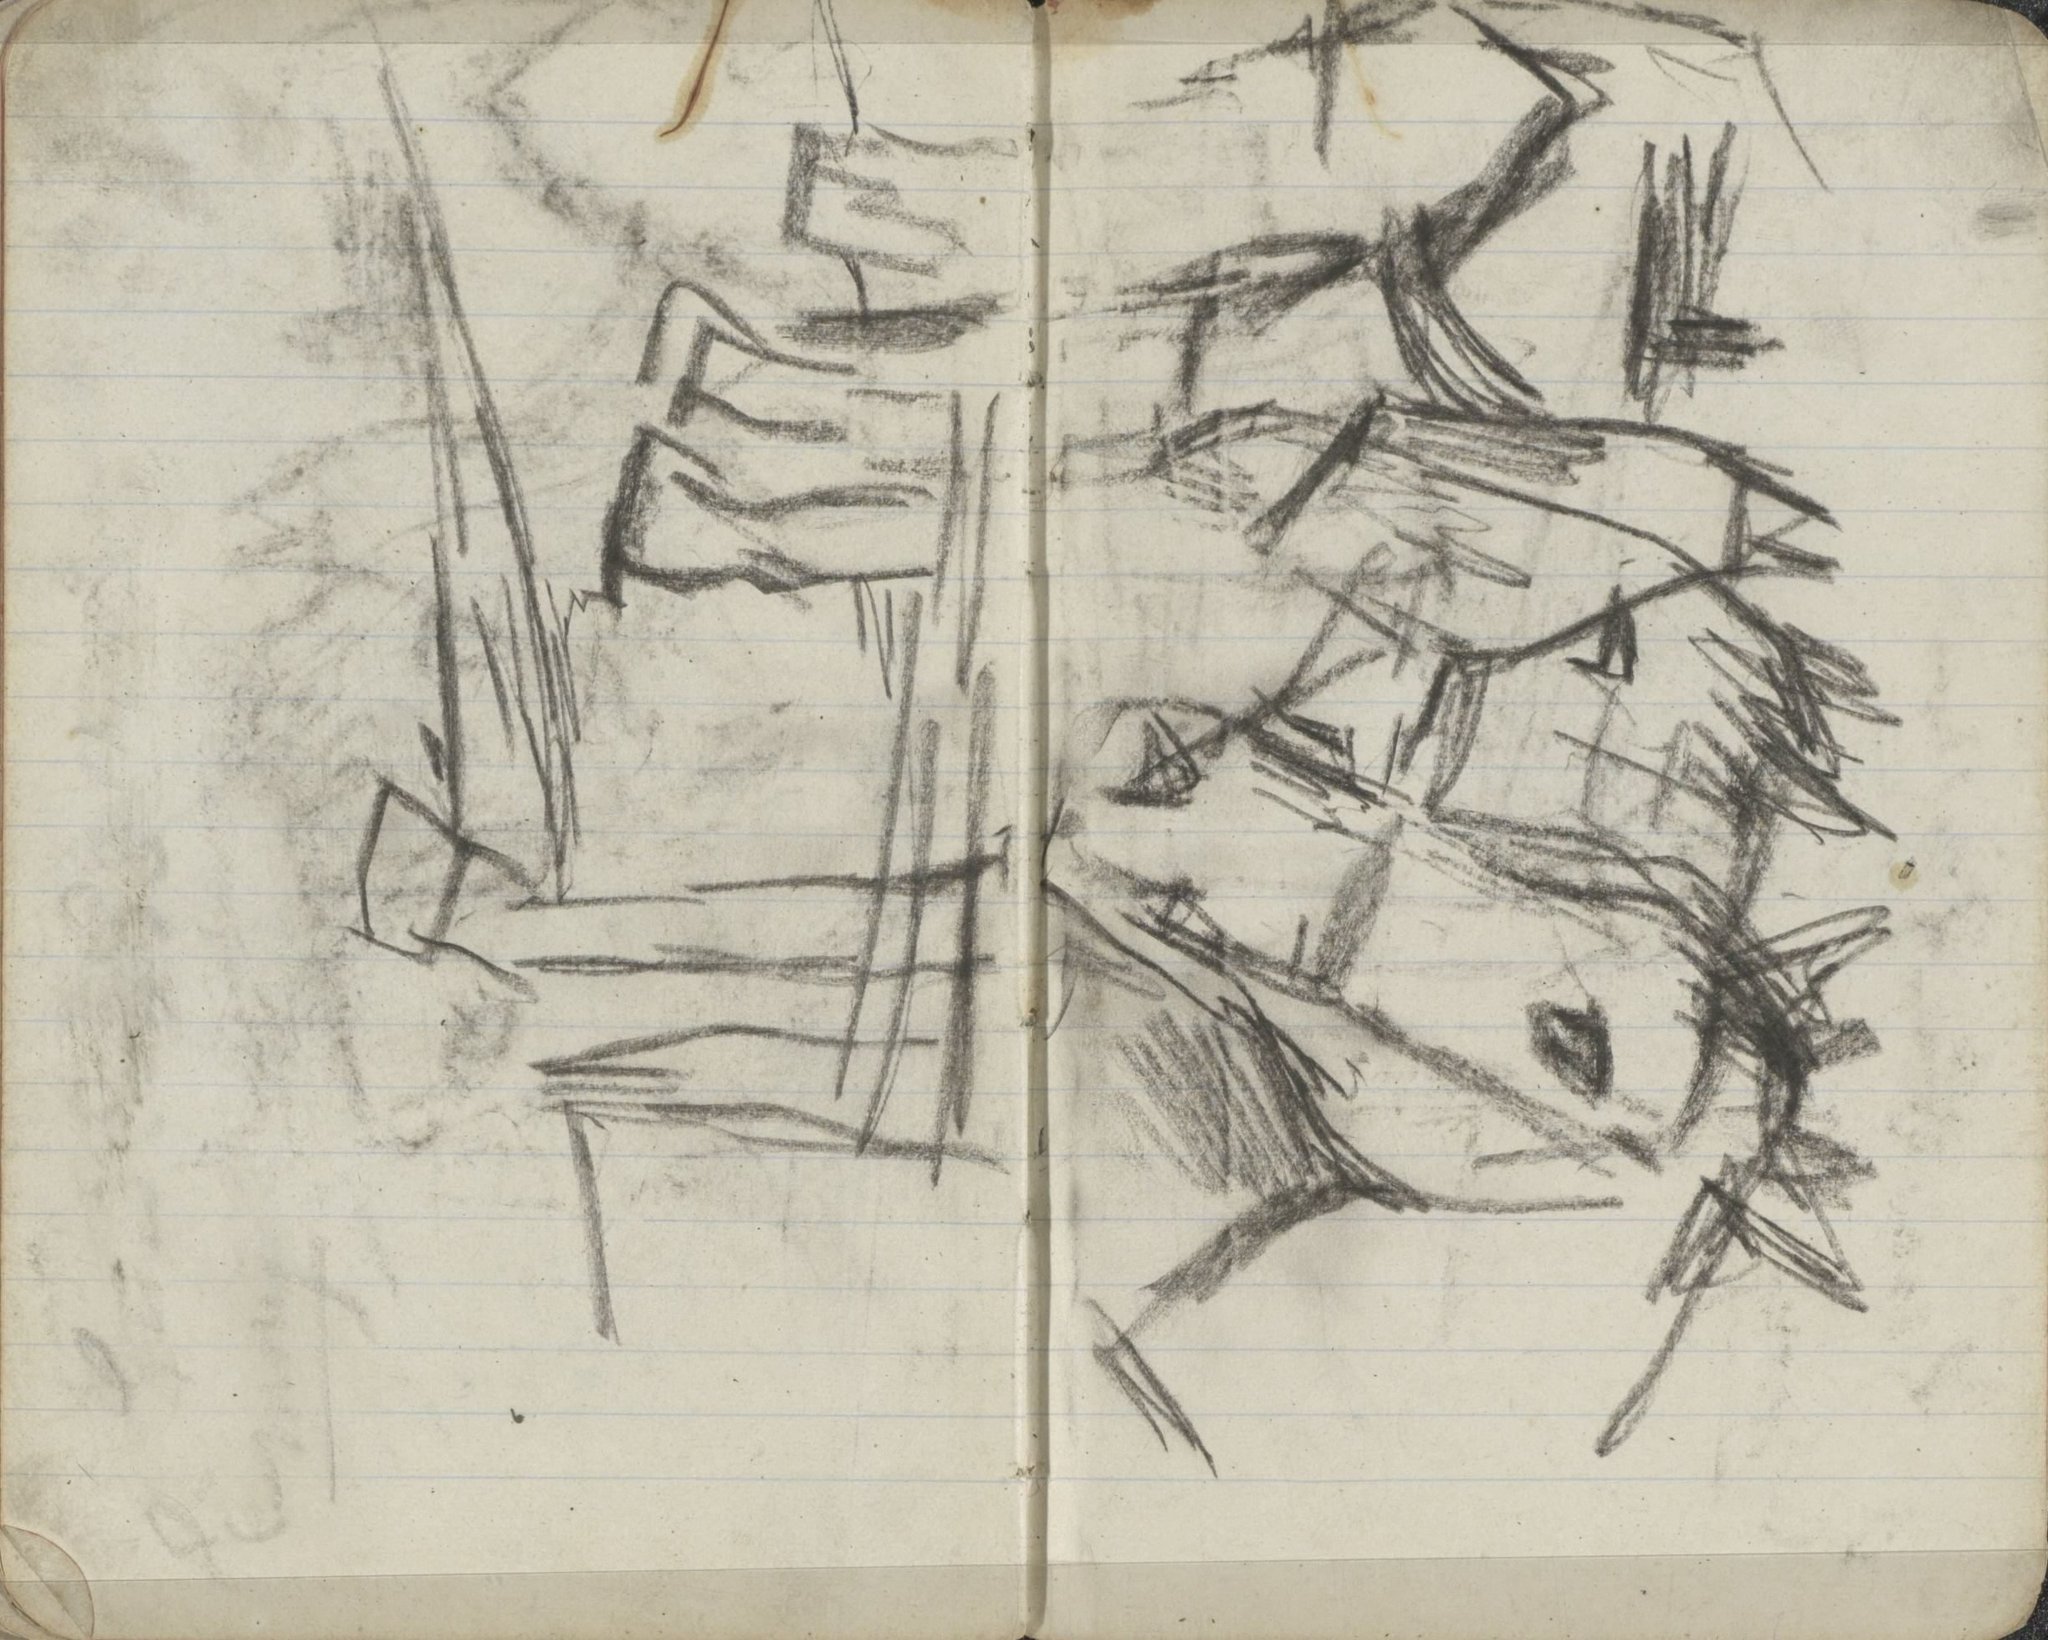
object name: sketchbook leaf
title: Trampaarden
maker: george hendrik breitner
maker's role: draughtsman, painter, print maker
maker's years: 1857-1923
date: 1893-1894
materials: chalk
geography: amsterdam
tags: horse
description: Pagina 68 en pagina 69 uit een schetsboek met 36 bladen.